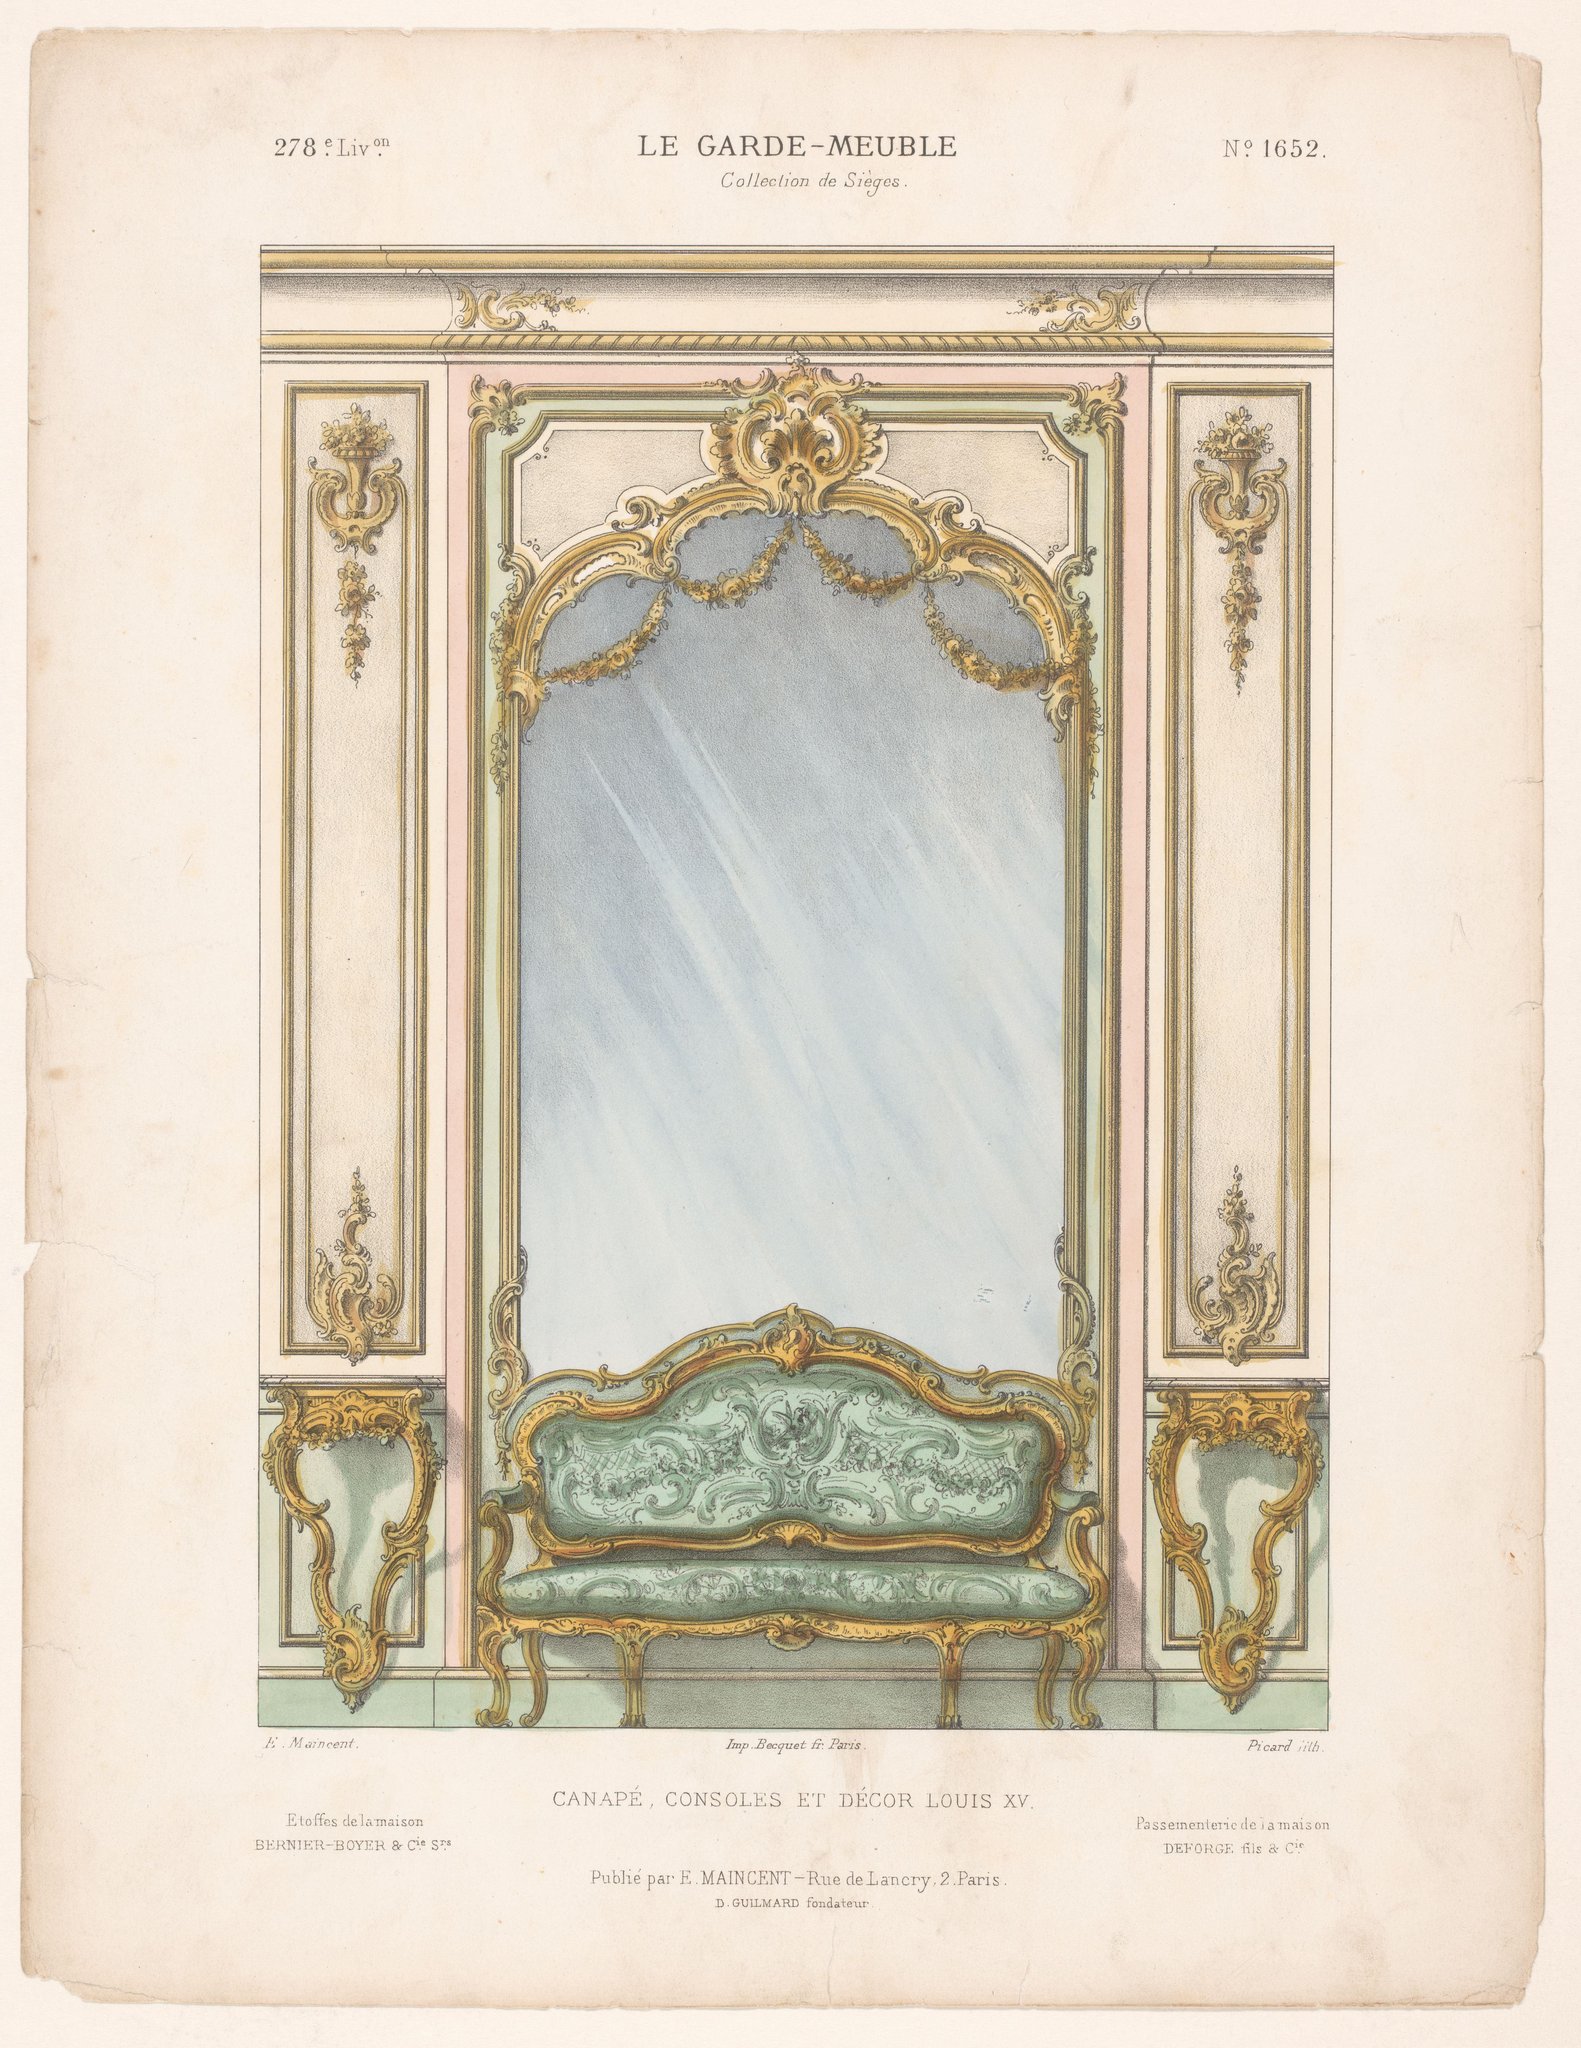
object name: print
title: Le garde-meuble / Collection de Sièges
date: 1885-1895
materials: paper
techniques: hand coloring, lithograph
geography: paris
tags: seating furniture, mirror, table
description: Ieder Livraison in de serie Le Garde-Meuble bevat negen platen: drie 'sièges' (zitmeubels), drie 'meubles' (diverse meubels zoals tafels en kasten) en drie 'tentures' (gordijnen en draperieën).